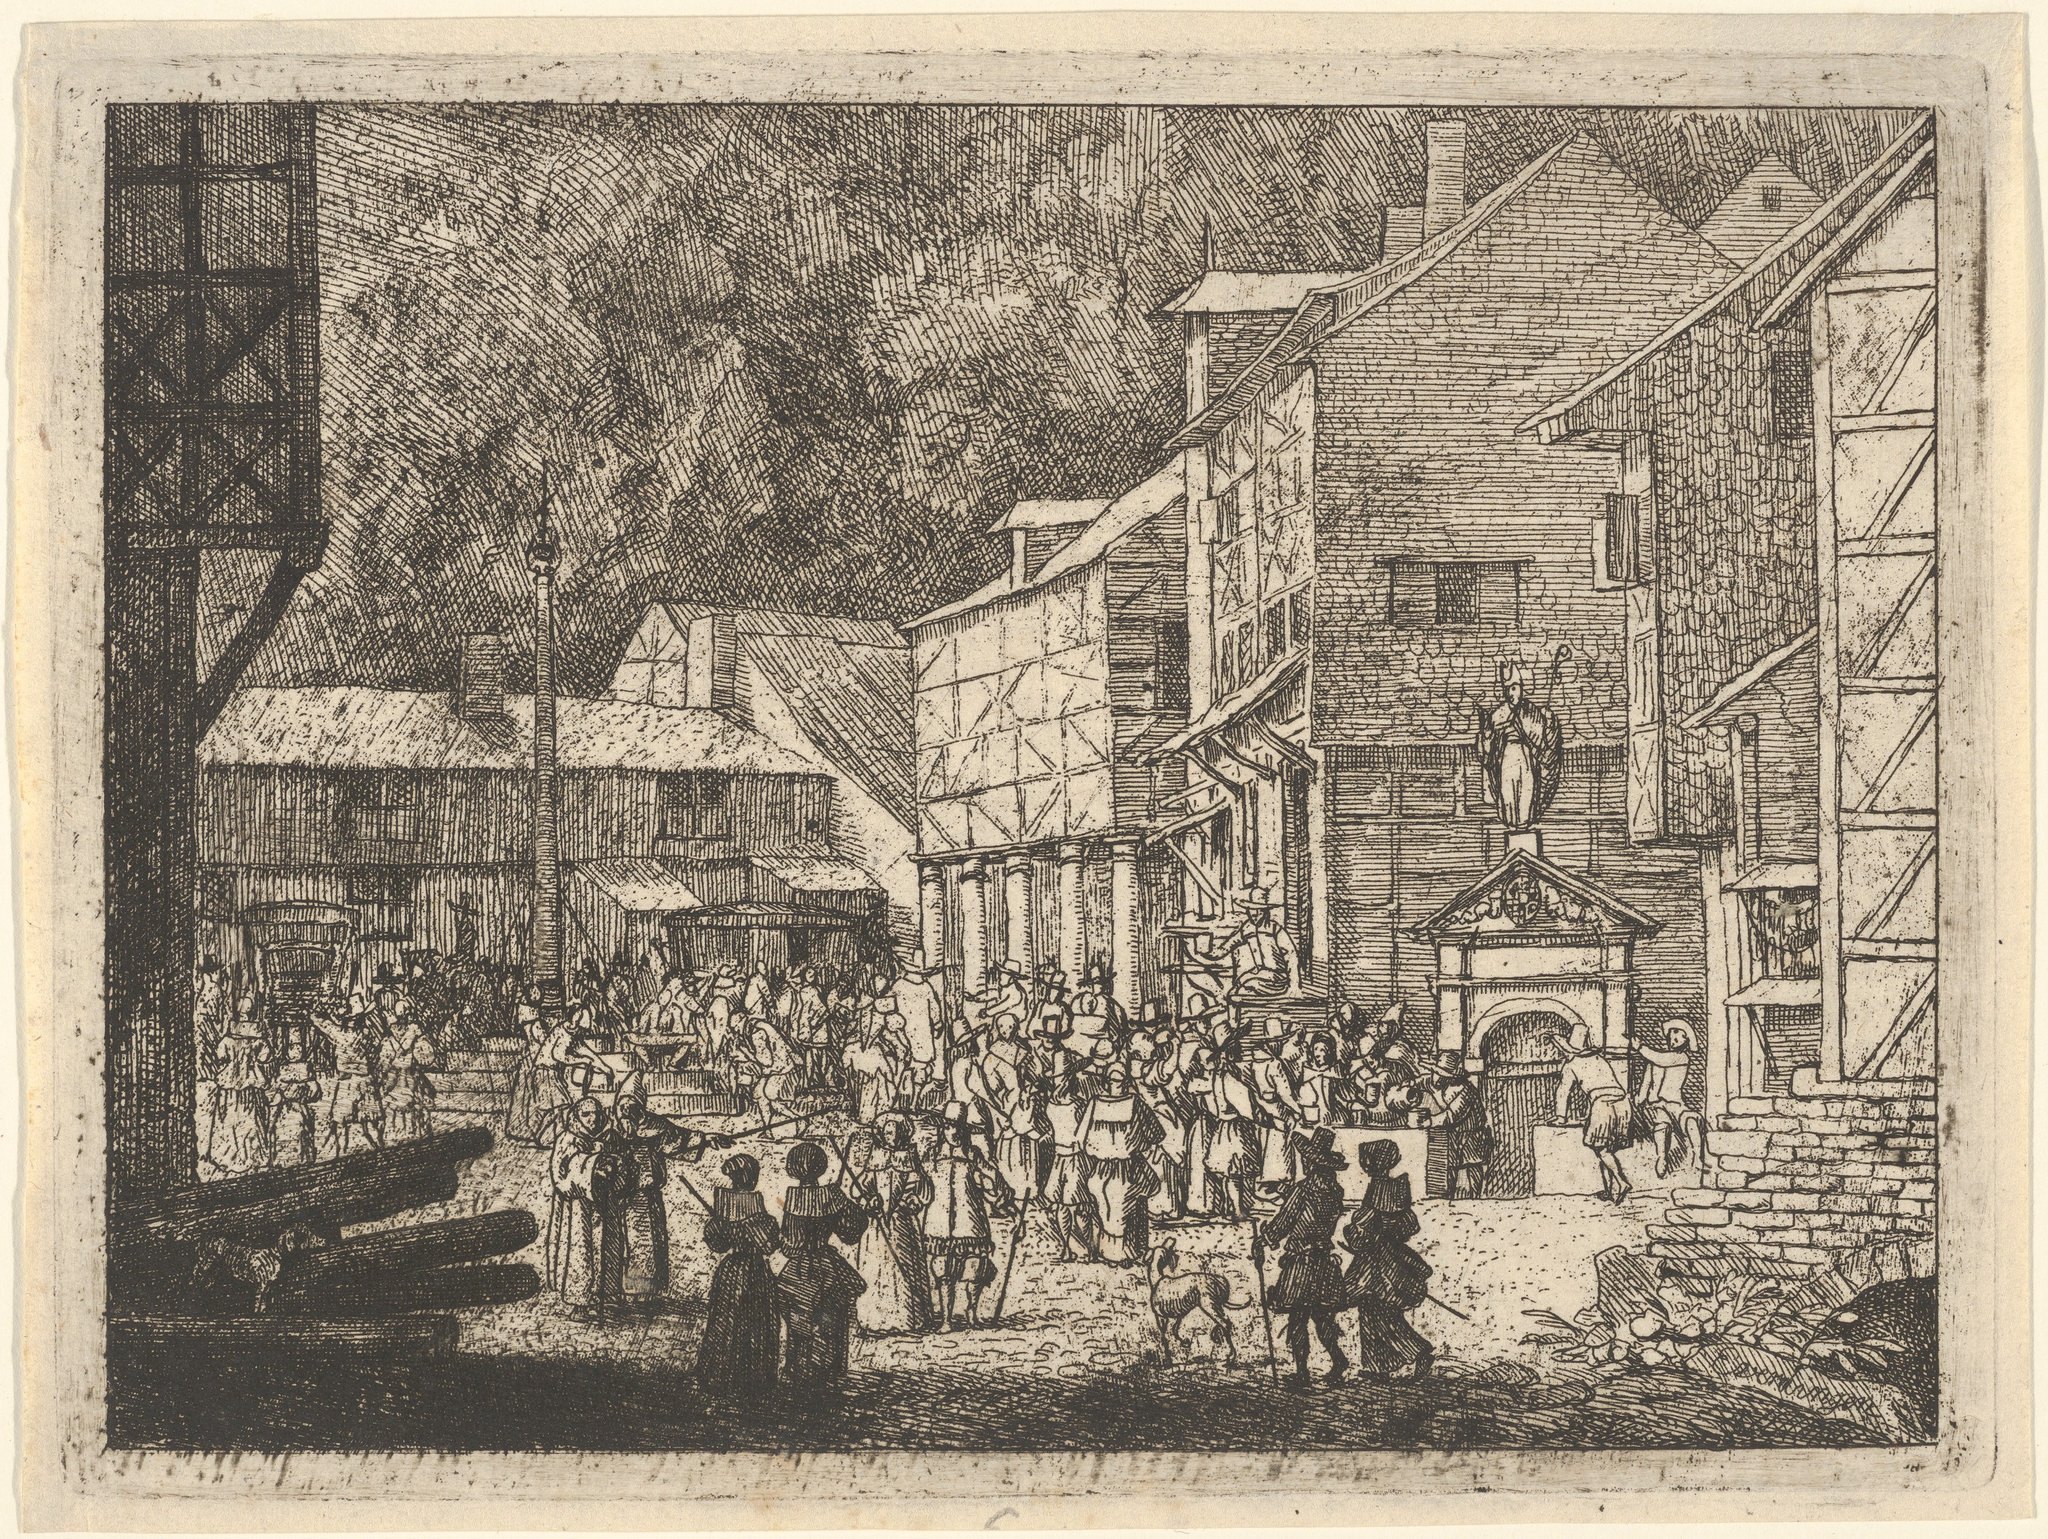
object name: print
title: The Second Spring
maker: allart van everdingen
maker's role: artist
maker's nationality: dutch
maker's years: 1621-1675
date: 1621-1675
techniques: engraving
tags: buildings,men,women,dogs,spring